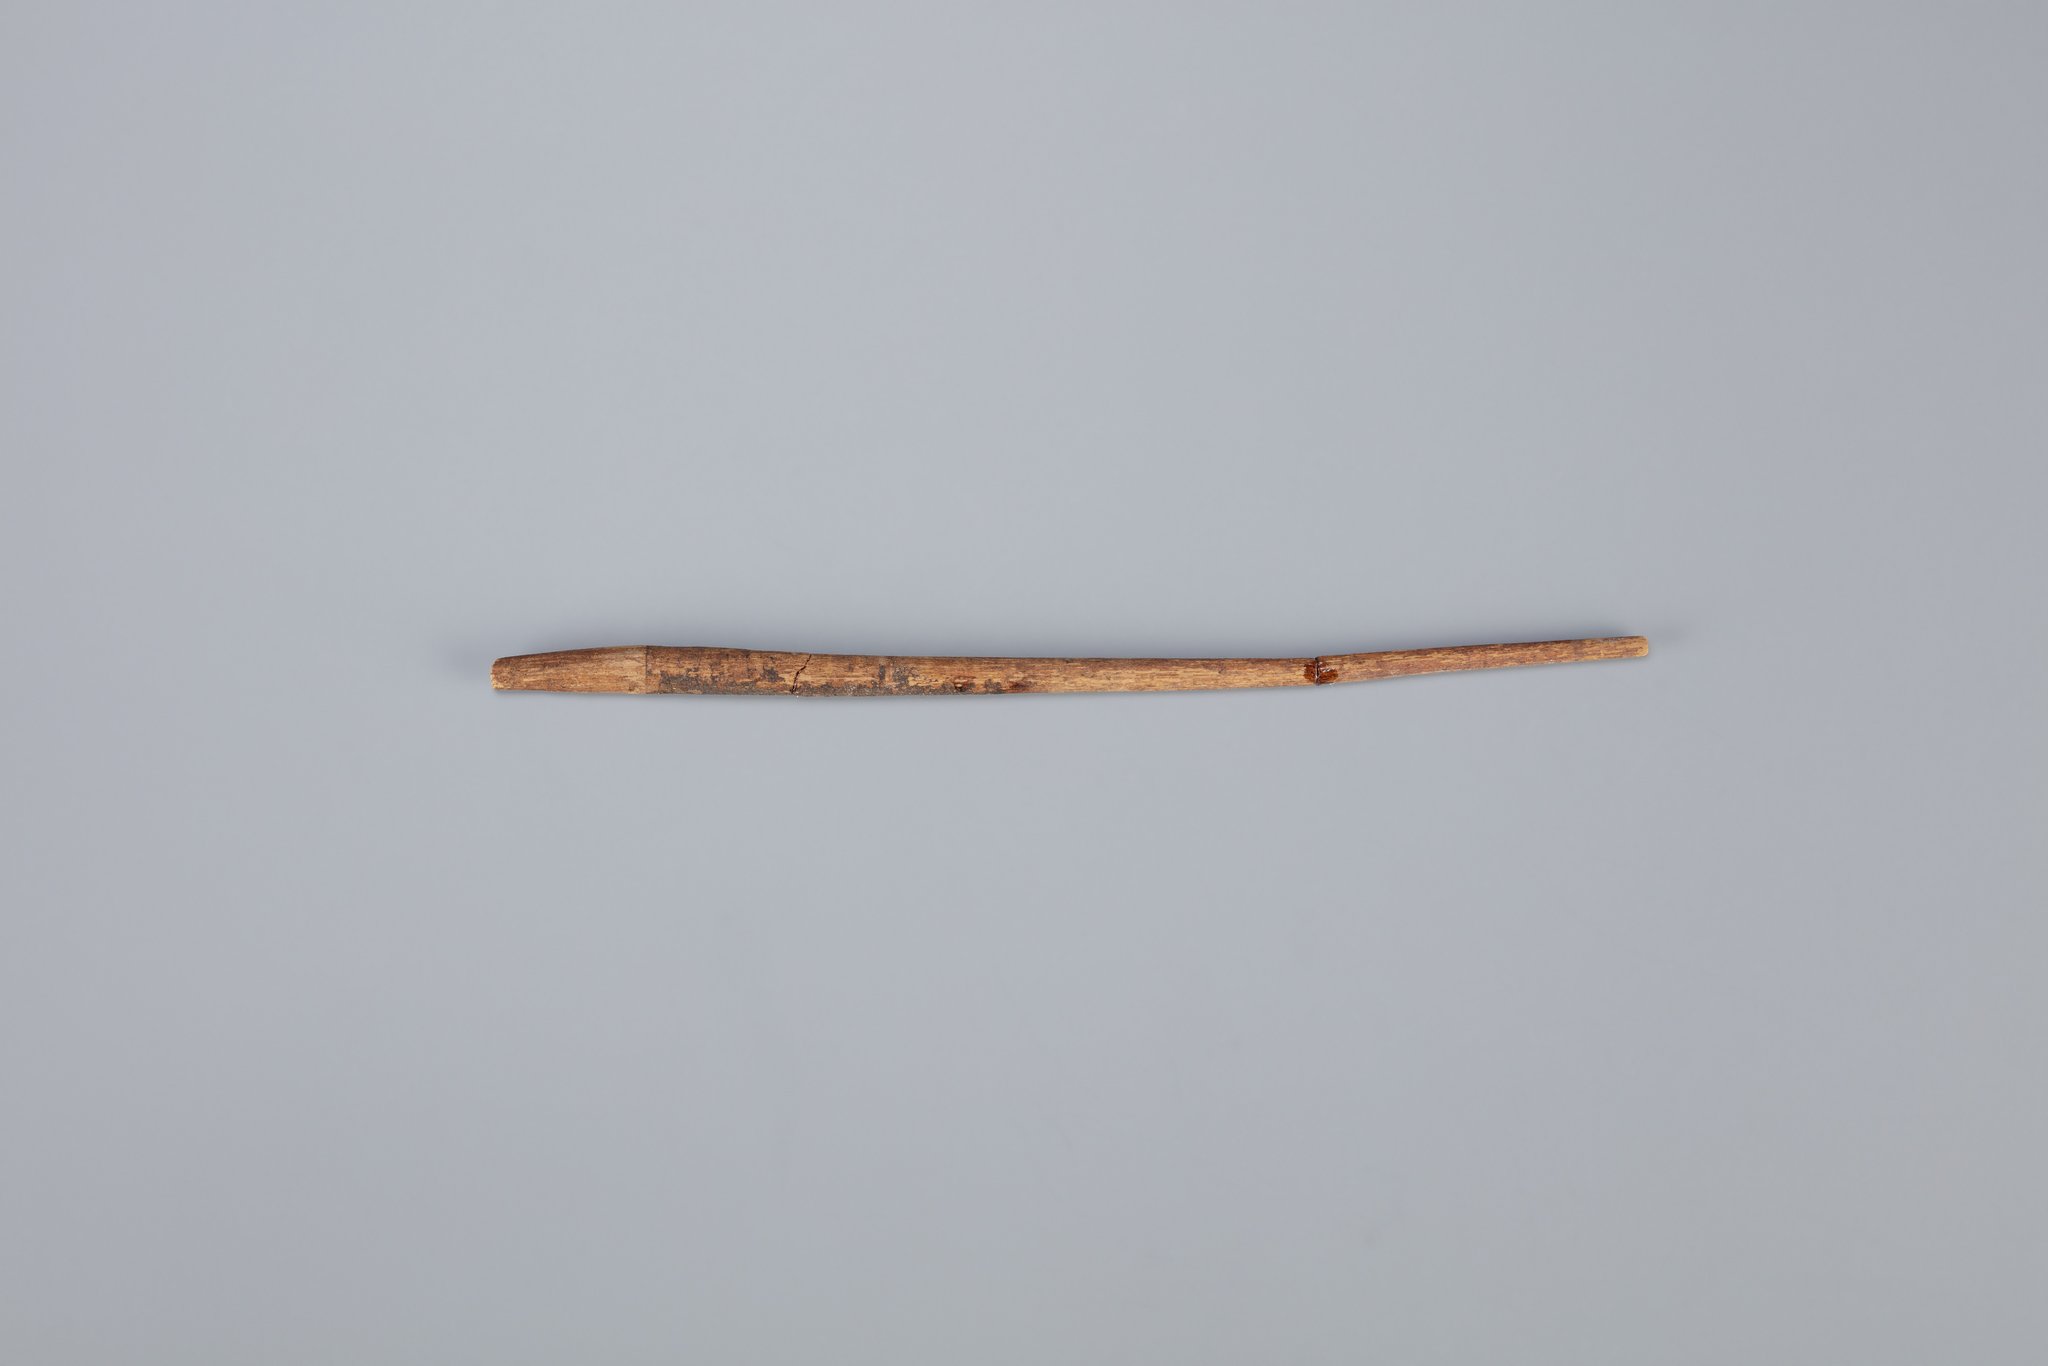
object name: arrow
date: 2030-1640 BCE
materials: wood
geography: egypt